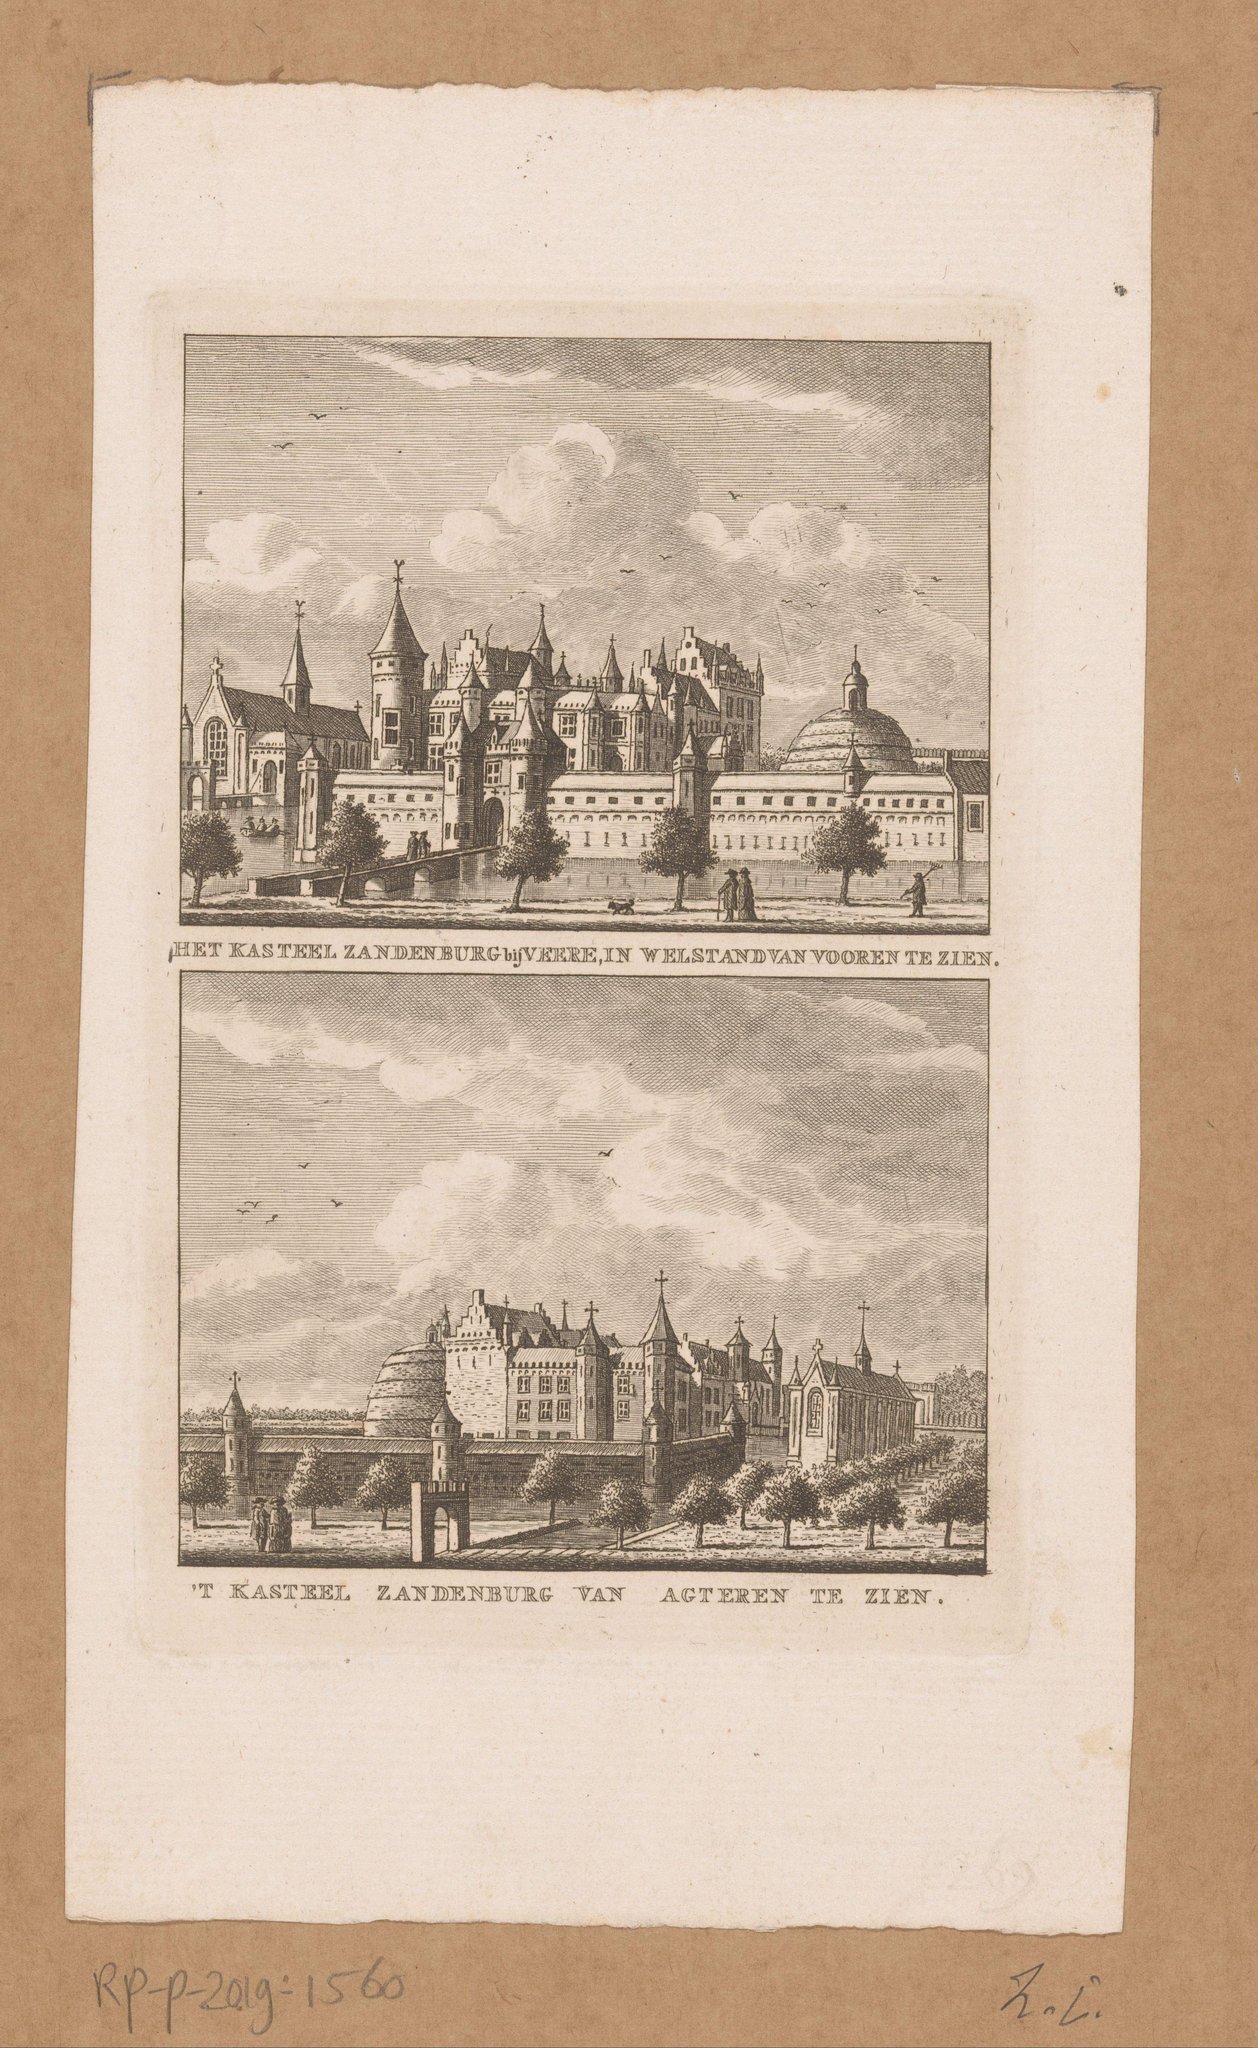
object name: print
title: Twee gezichten op Slot Zandenburg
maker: carel frederik bendorp (i)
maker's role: print maker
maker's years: 1736-1814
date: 1786-1792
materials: paper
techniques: etching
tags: village street (+ city(-scape) with figures, staffage)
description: Prent uit: Vaderlandsche gezichten, of afbeeldingen van den tegenwoordigen staat der Vereenigde Nederlanden (…). Amsterdam: Hendrik Gartman, Willem Vermandel en Jan Willem Smit, 1786-1792. Uitgegeven in afleveringen met ieder een eigen bifolium en inhoudsopgave. Alle prenten in deze publicatie zijn gegraveerd door Carel Frederik Bendorp (I) en, in de meeste gevallen, gebaseerd op tekeningen van Jan Bulthuis.